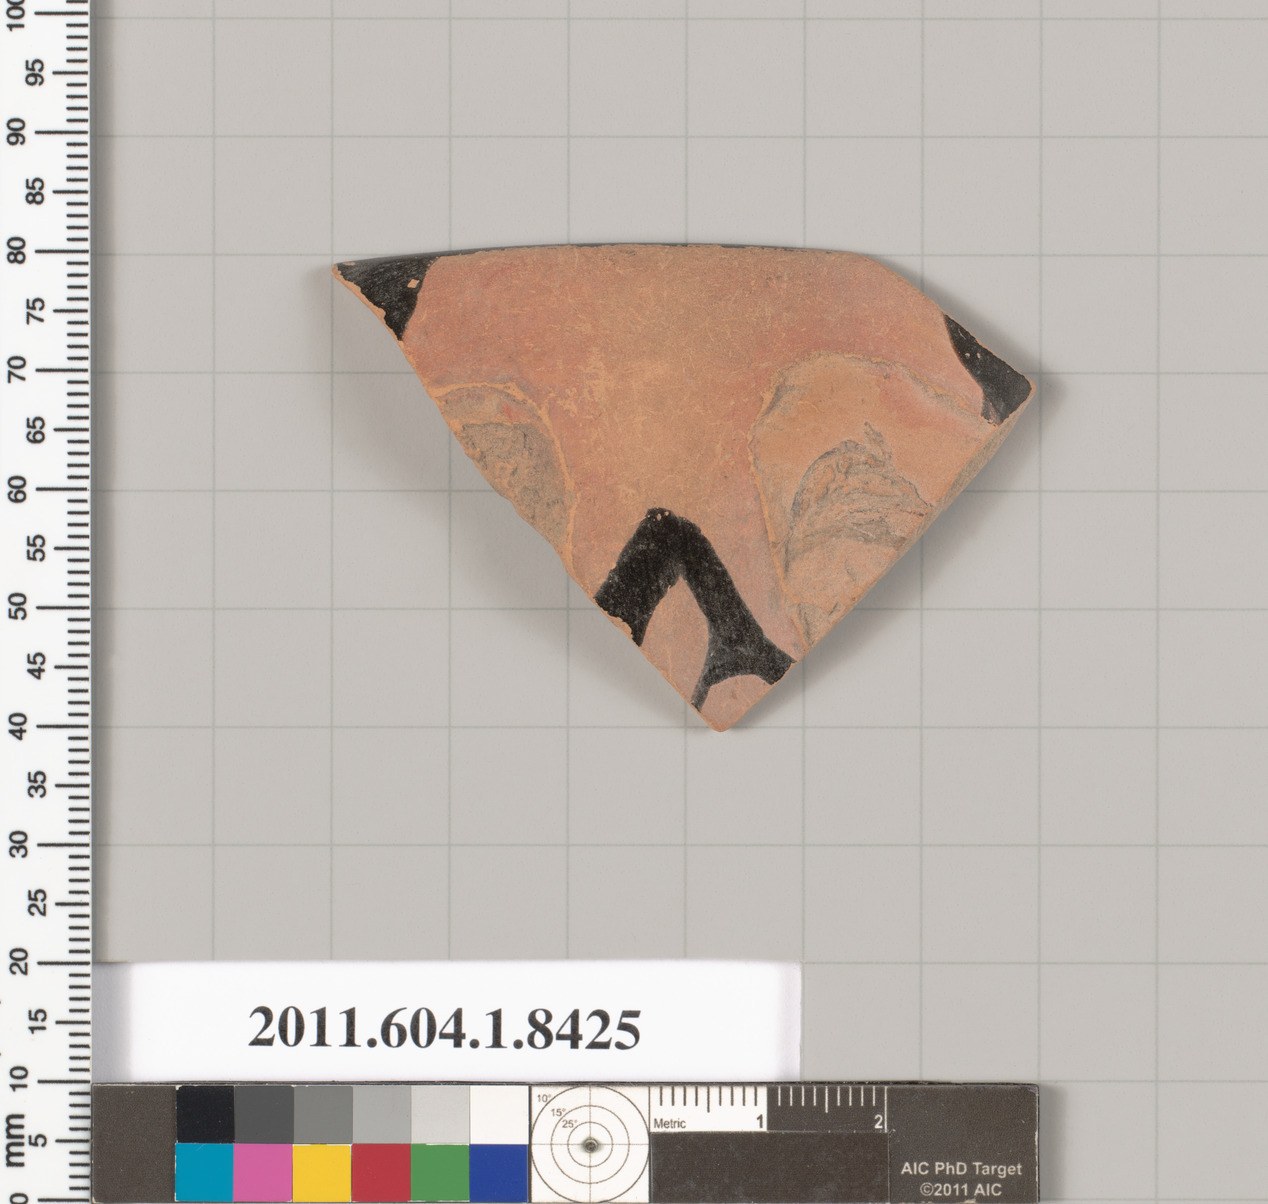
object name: kylix fragment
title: Terracotta rim fragment of a kylix (drinking cup)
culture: greek, attic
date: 467-435 BCE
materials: terracotta